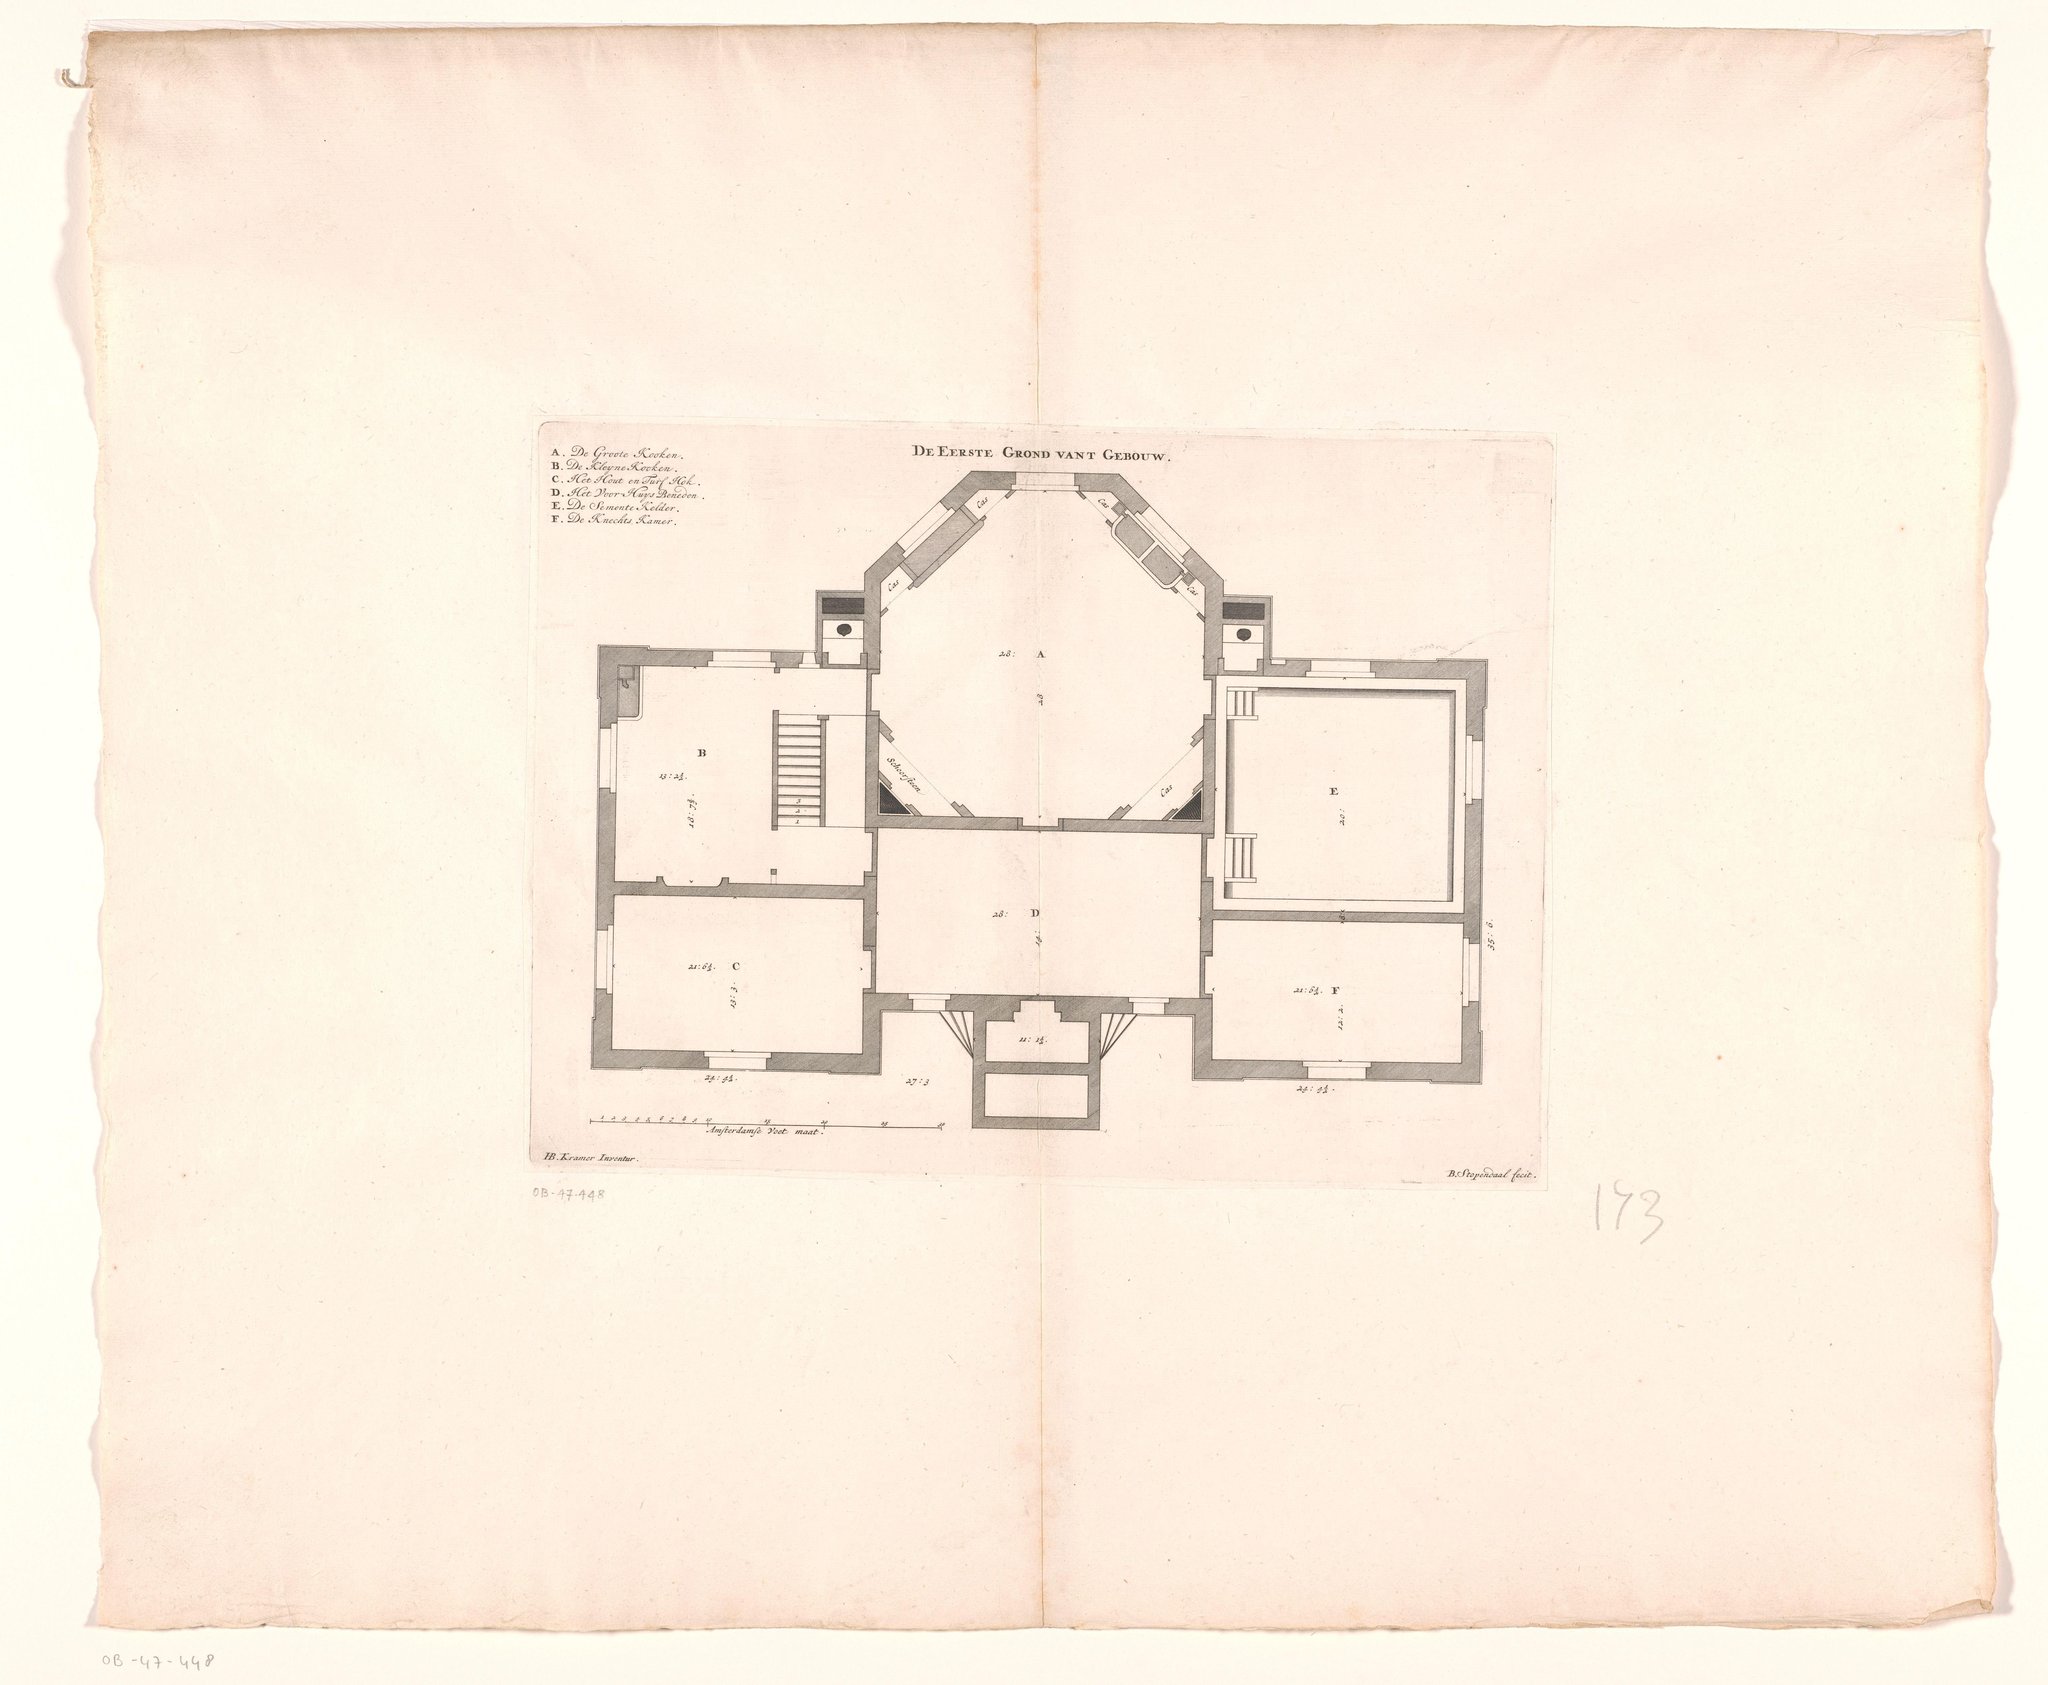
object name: ornament print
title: De Eerste Grond van t Gebouw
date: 1687-1693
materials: paper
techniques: engraving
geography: amsterdam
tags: plan ~ architecture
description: Plattegrond van buitenplaats De Nes of Realeneiland te Vreeland. Het voor de Amsterdamse familie Reaal in 1687 gebouwde buitenhuis lag op een eiland in de Vecht.